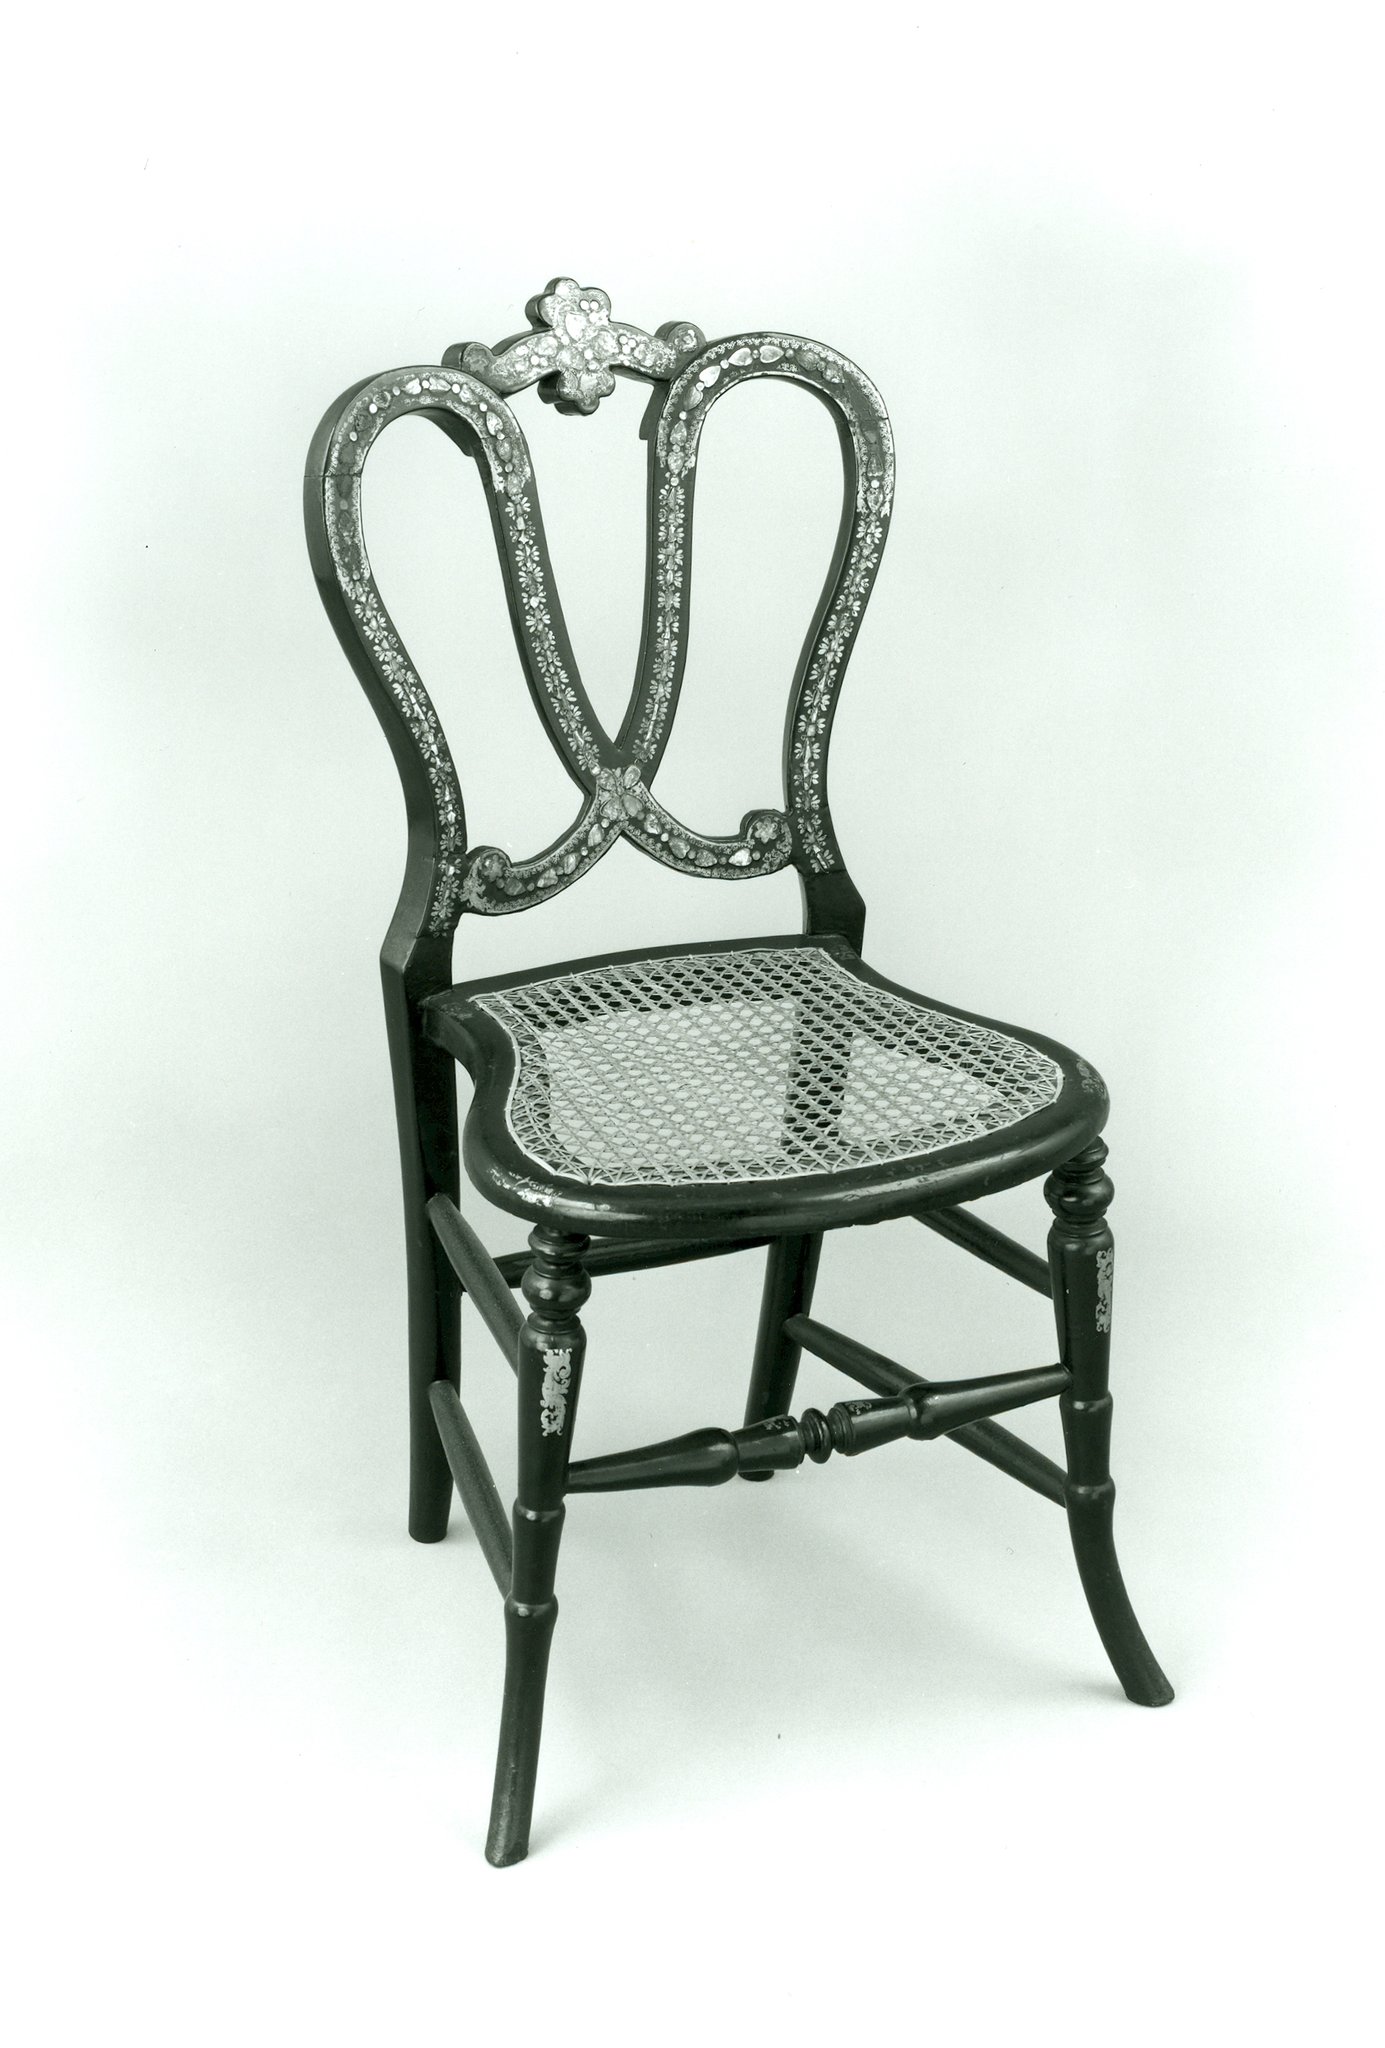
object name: chair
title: Papier-mâchè side chair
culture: british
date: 1830-1860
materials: lacquer, mother of pearl, paper, wood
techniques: caning, gilding, painting